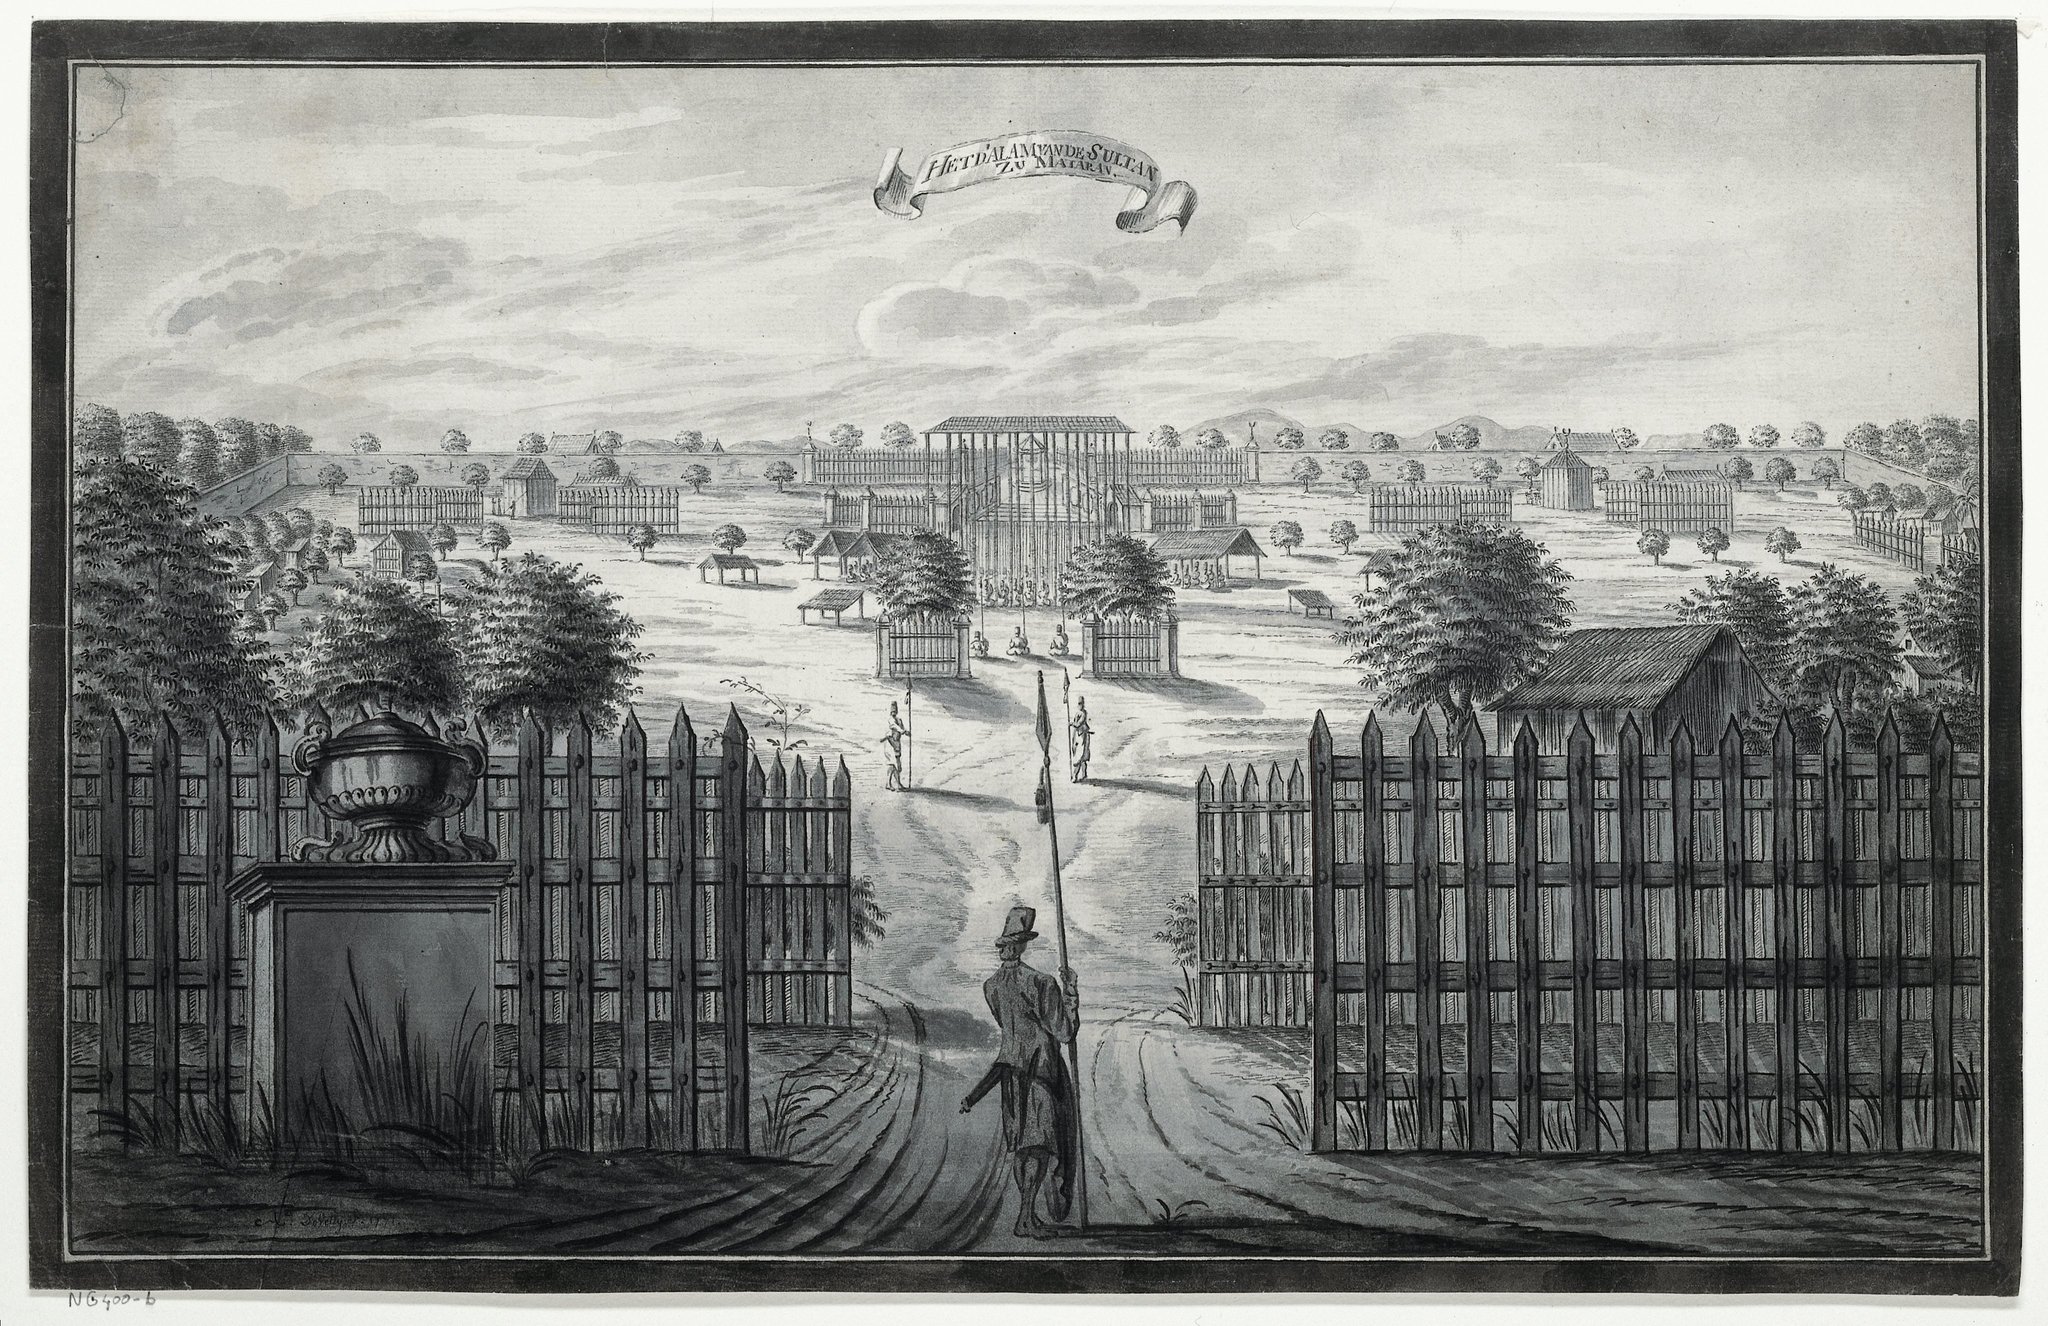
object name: drawing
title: Het d'Alam van de sultan Zu Mataran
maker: a. de nelly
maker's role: draughtsman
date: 1771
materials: ink, paper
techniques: brush, pen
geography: jogjakarta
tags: fortress, palace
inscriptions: inscription: ‘HET D'ALAM VAN DE SULTAN / ZU MATARAN’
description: Gezicht op de kraton te Djocjakarta (gebouwd in 1760), een ommuurd terrein met verschillende bouwsels en hekken. Op de voorgrond twee houten hekken achter elkaar, links stenen vaas op sokkel. Tussen de hekken wachter met lans. Achterin groep zittende mensen onder afdak op hoge palen. Opschrift m.b. in banderol, gesigneerd en gedateerd.